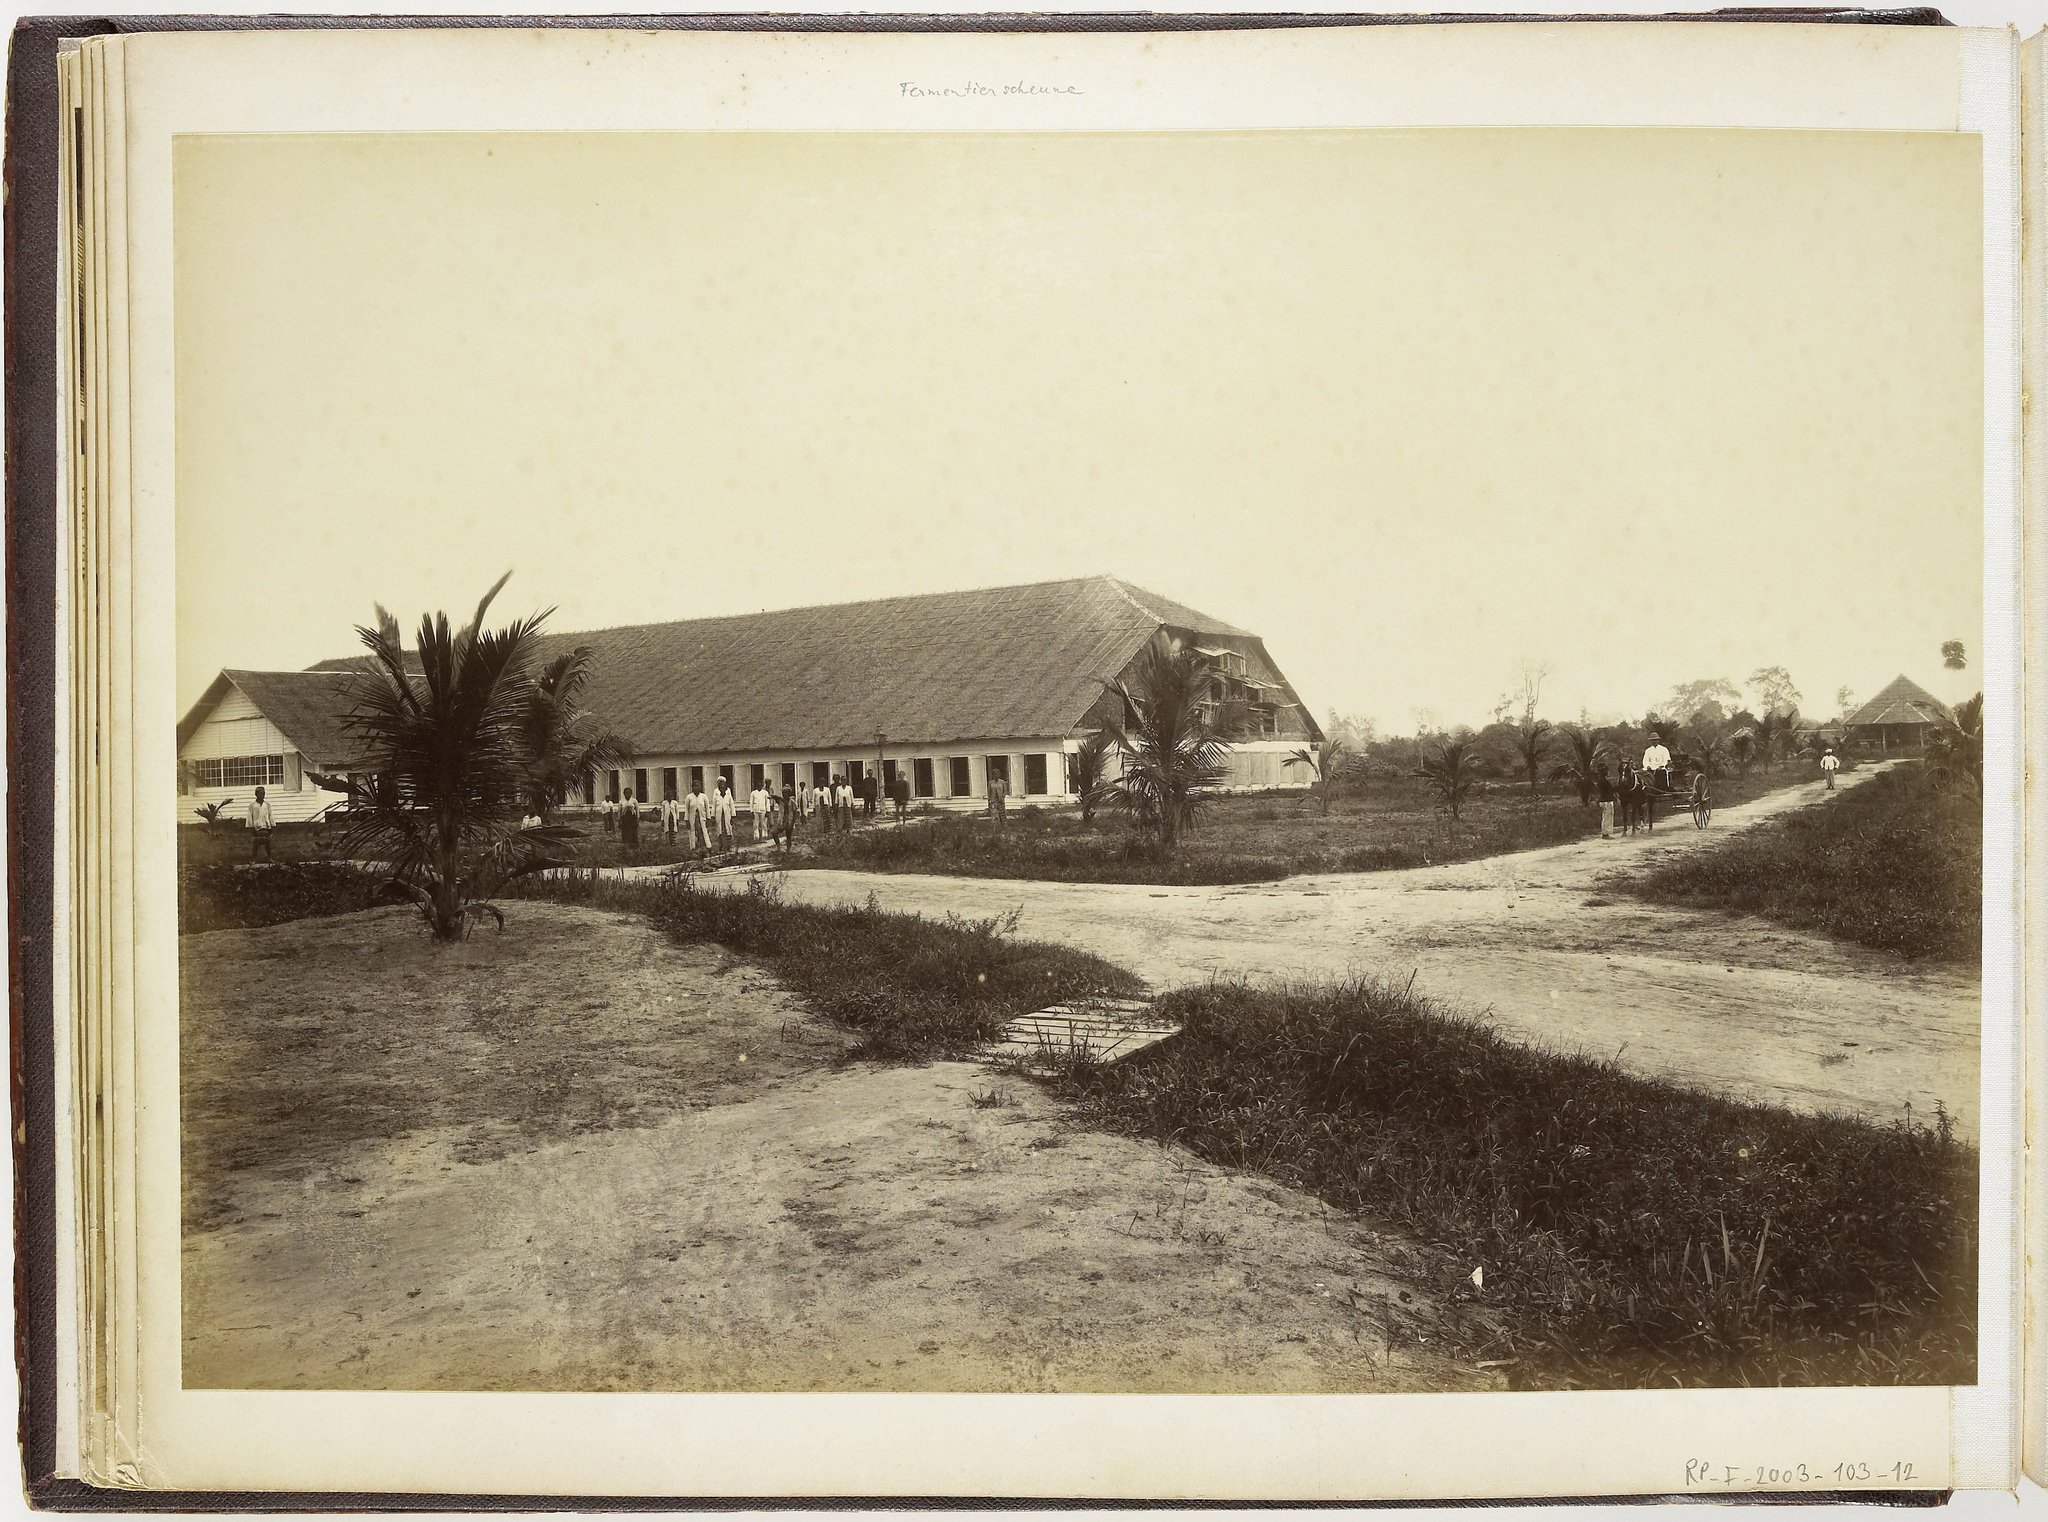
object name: photograph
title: Fermenteerschuur, Langkat Sumatra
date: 1900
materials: cardboard, paper, photographic support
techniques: albumen print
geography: bindjai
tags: sumatra